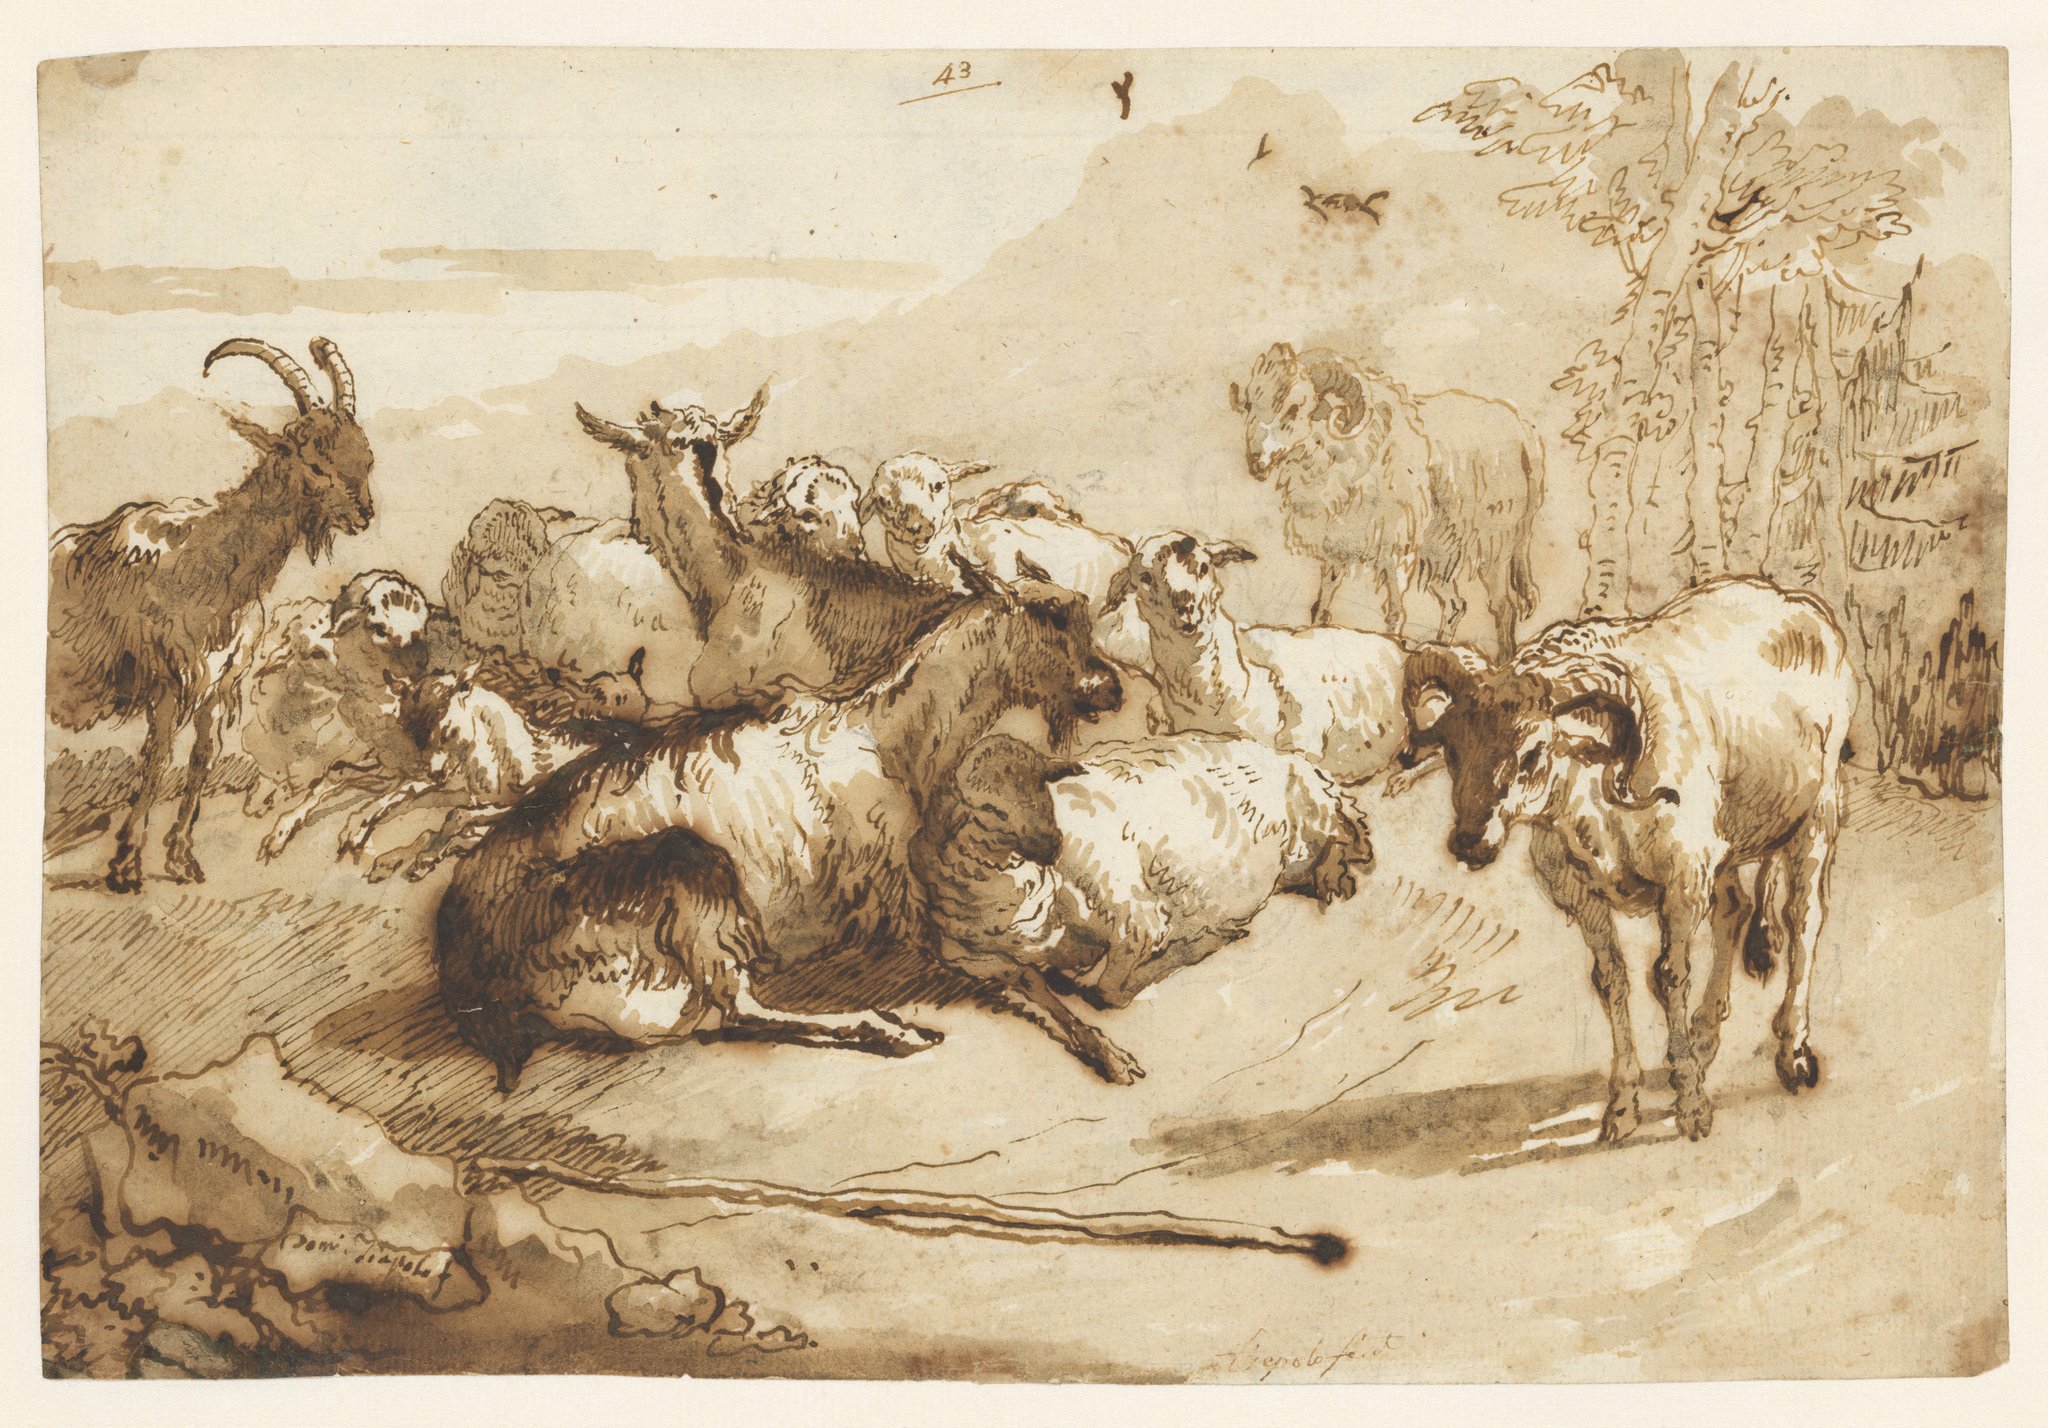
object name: drawing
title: Goats and Sheep in a Landscape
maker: giovanni domenico tiepolo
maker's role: artist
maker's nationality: italian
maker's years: 1727-1804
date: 1760-1761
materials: chalk, ink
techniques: pen, wash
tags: goats,sheep